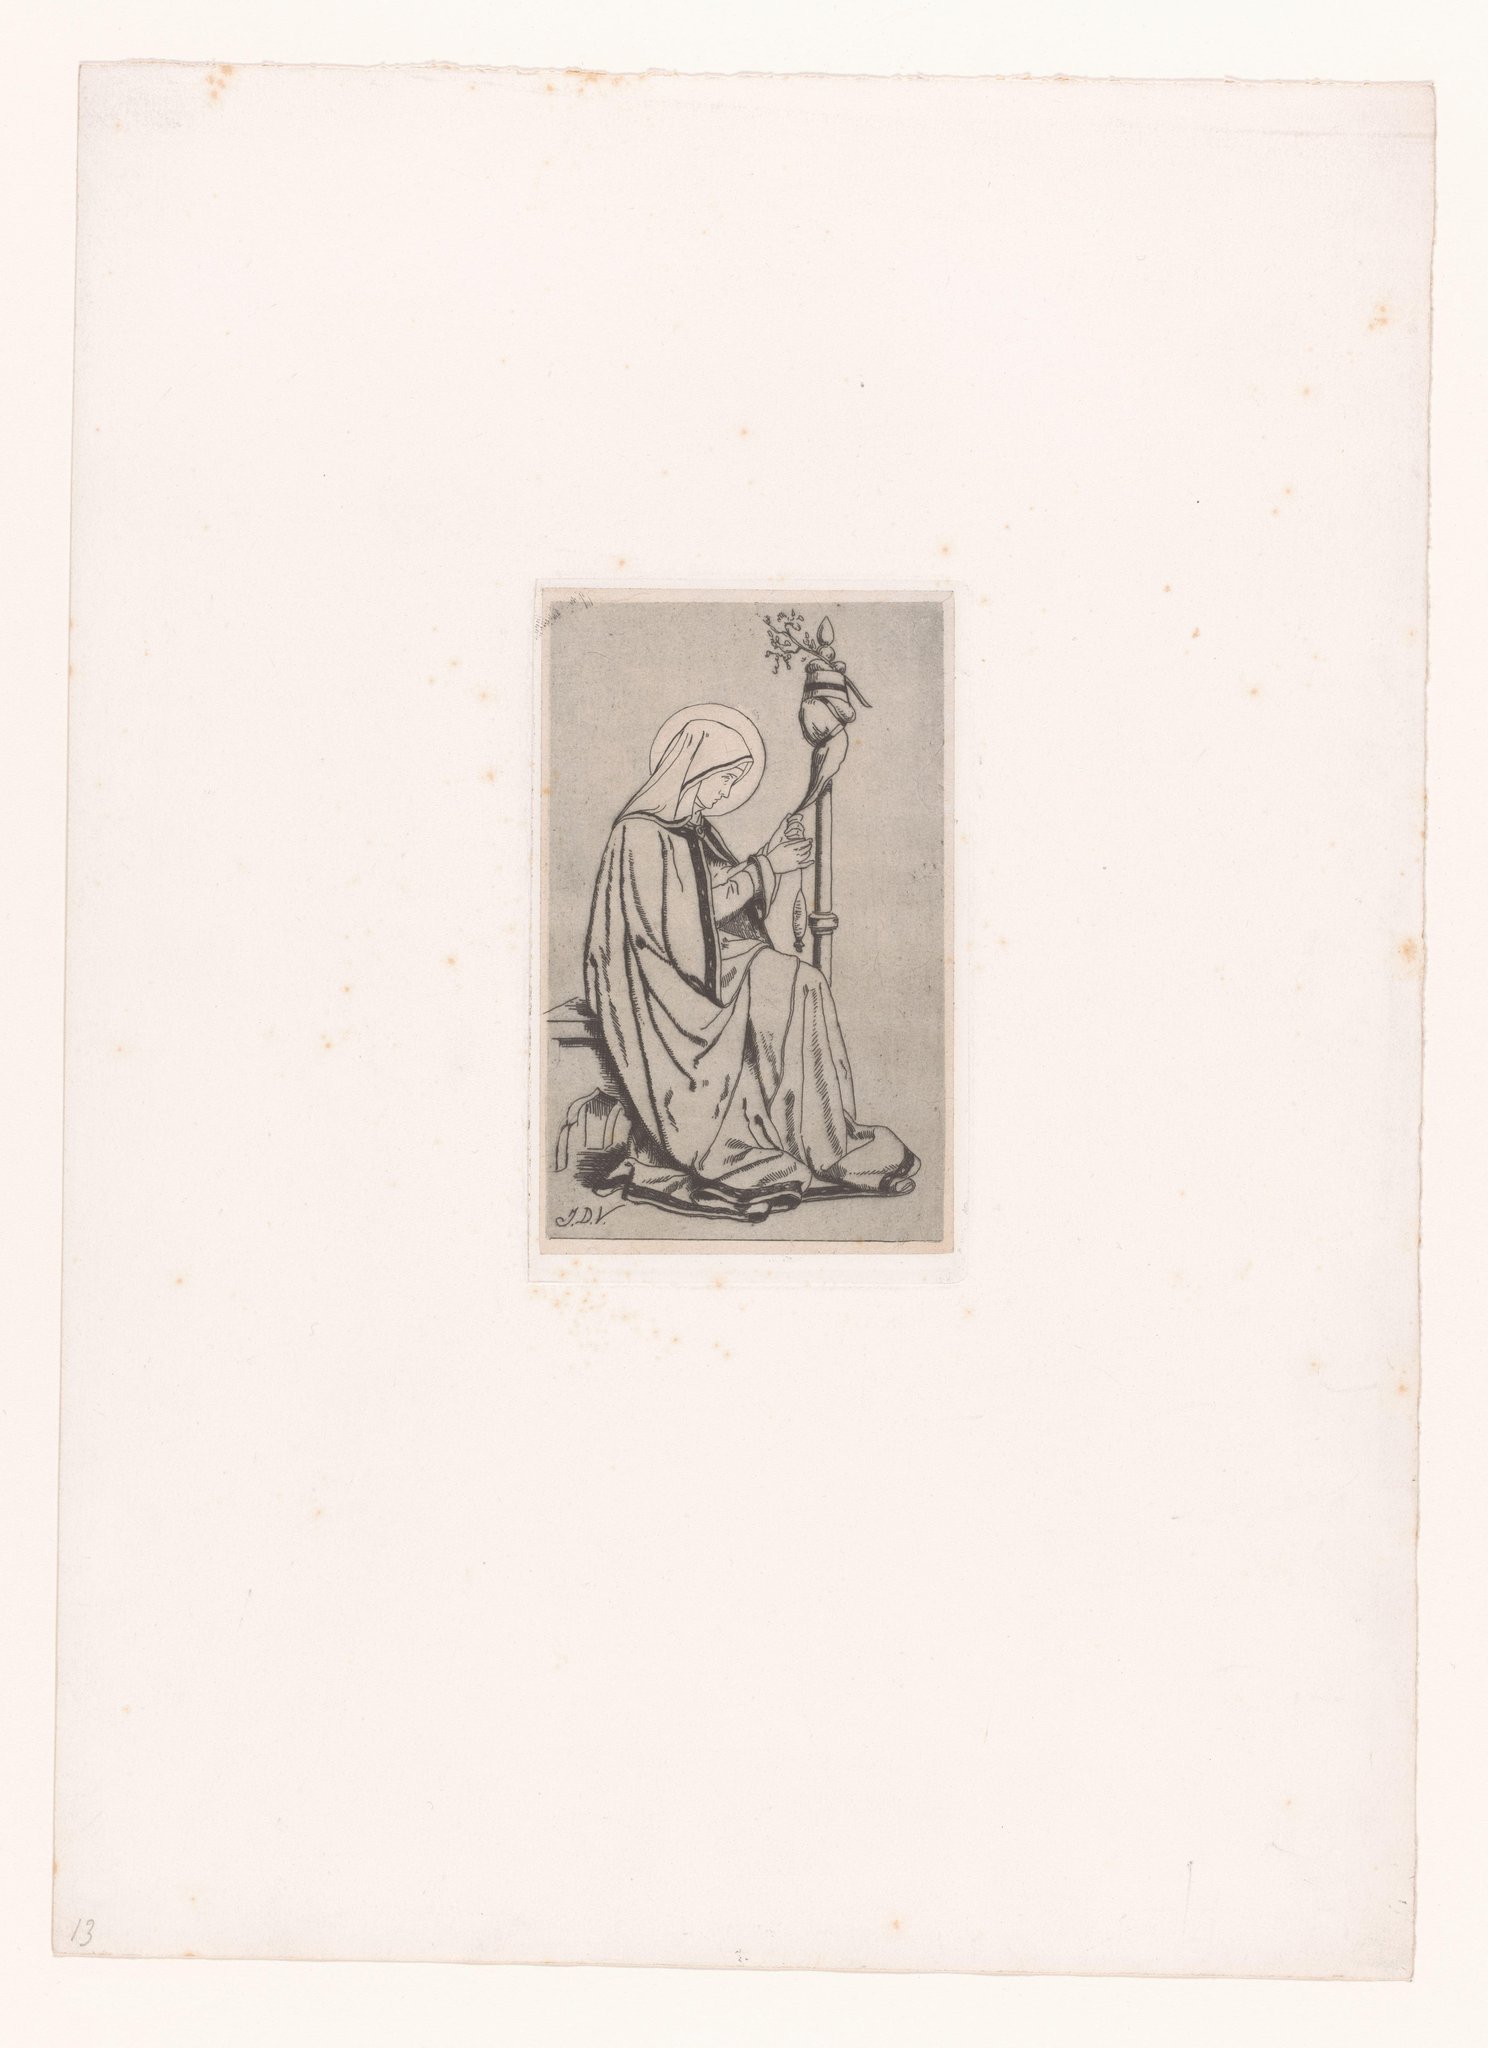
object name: print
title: Spinnende heilige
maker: juliaan de vriendt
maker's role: print maker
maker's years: 1842-1935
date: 1852-1913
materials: paper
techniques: etching, intaglio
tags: nimbus, halo ~ radiance emanating from persons or things, female saints, spinning (manufacture of yarn)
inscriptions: collector's mark: Lugt 2228